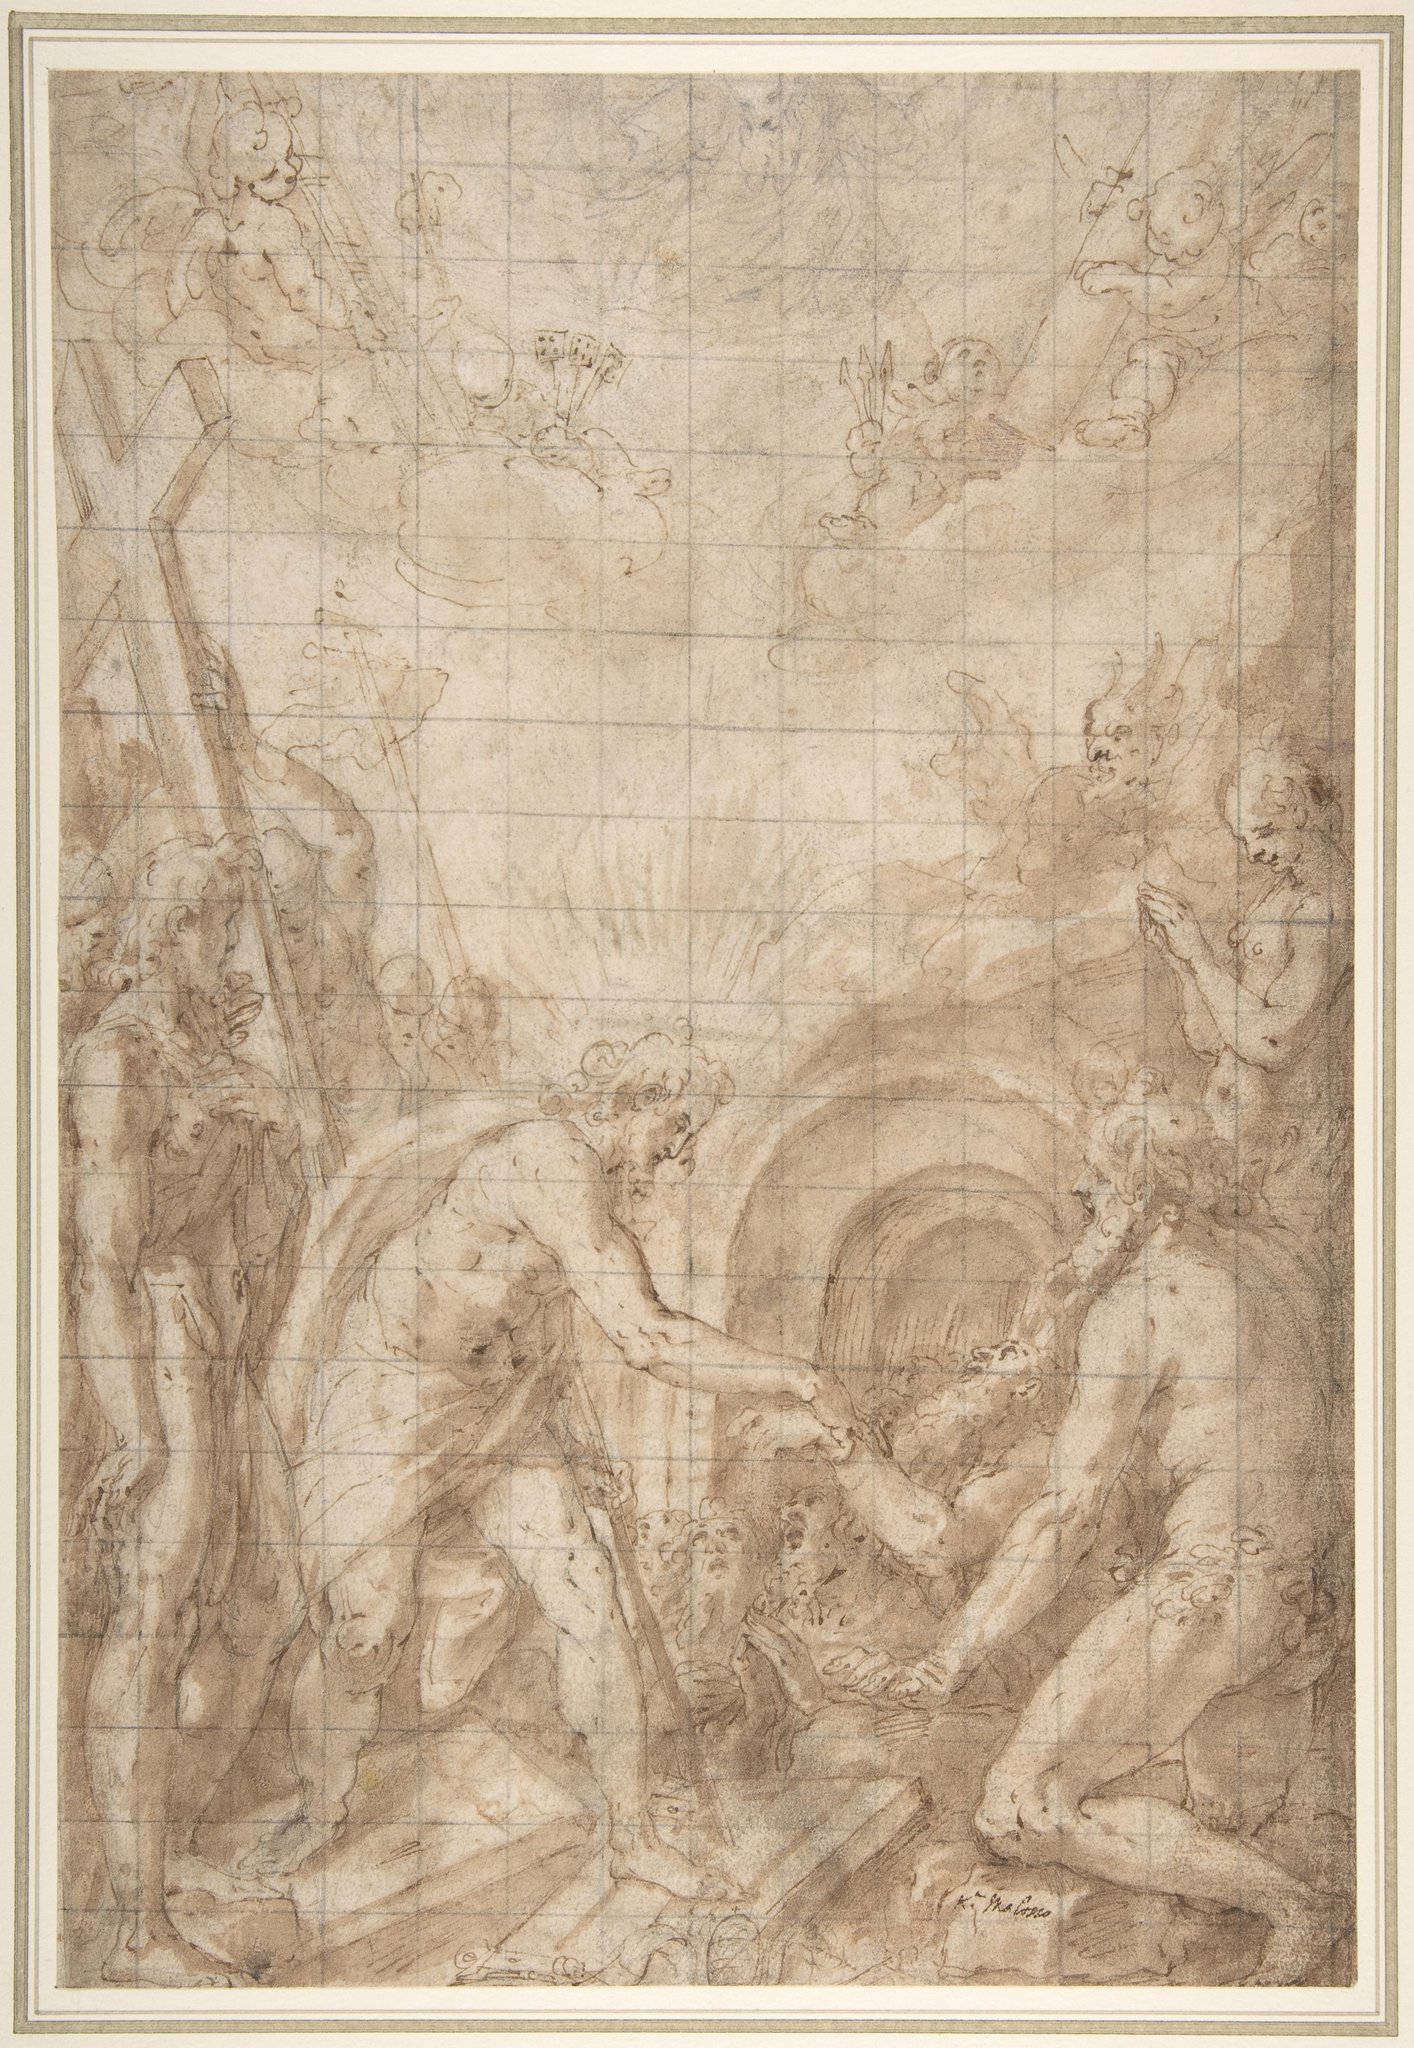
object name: drawing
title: Christ in Limbo: Design for the Standard of a Confraternity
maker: filippo bellini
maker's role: artist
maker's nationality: italian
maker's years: 1550-1604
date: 1550-1604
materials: chalk, ink, drawing material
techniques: brush, pen, drawing, wash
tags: men,angels,christ,cross